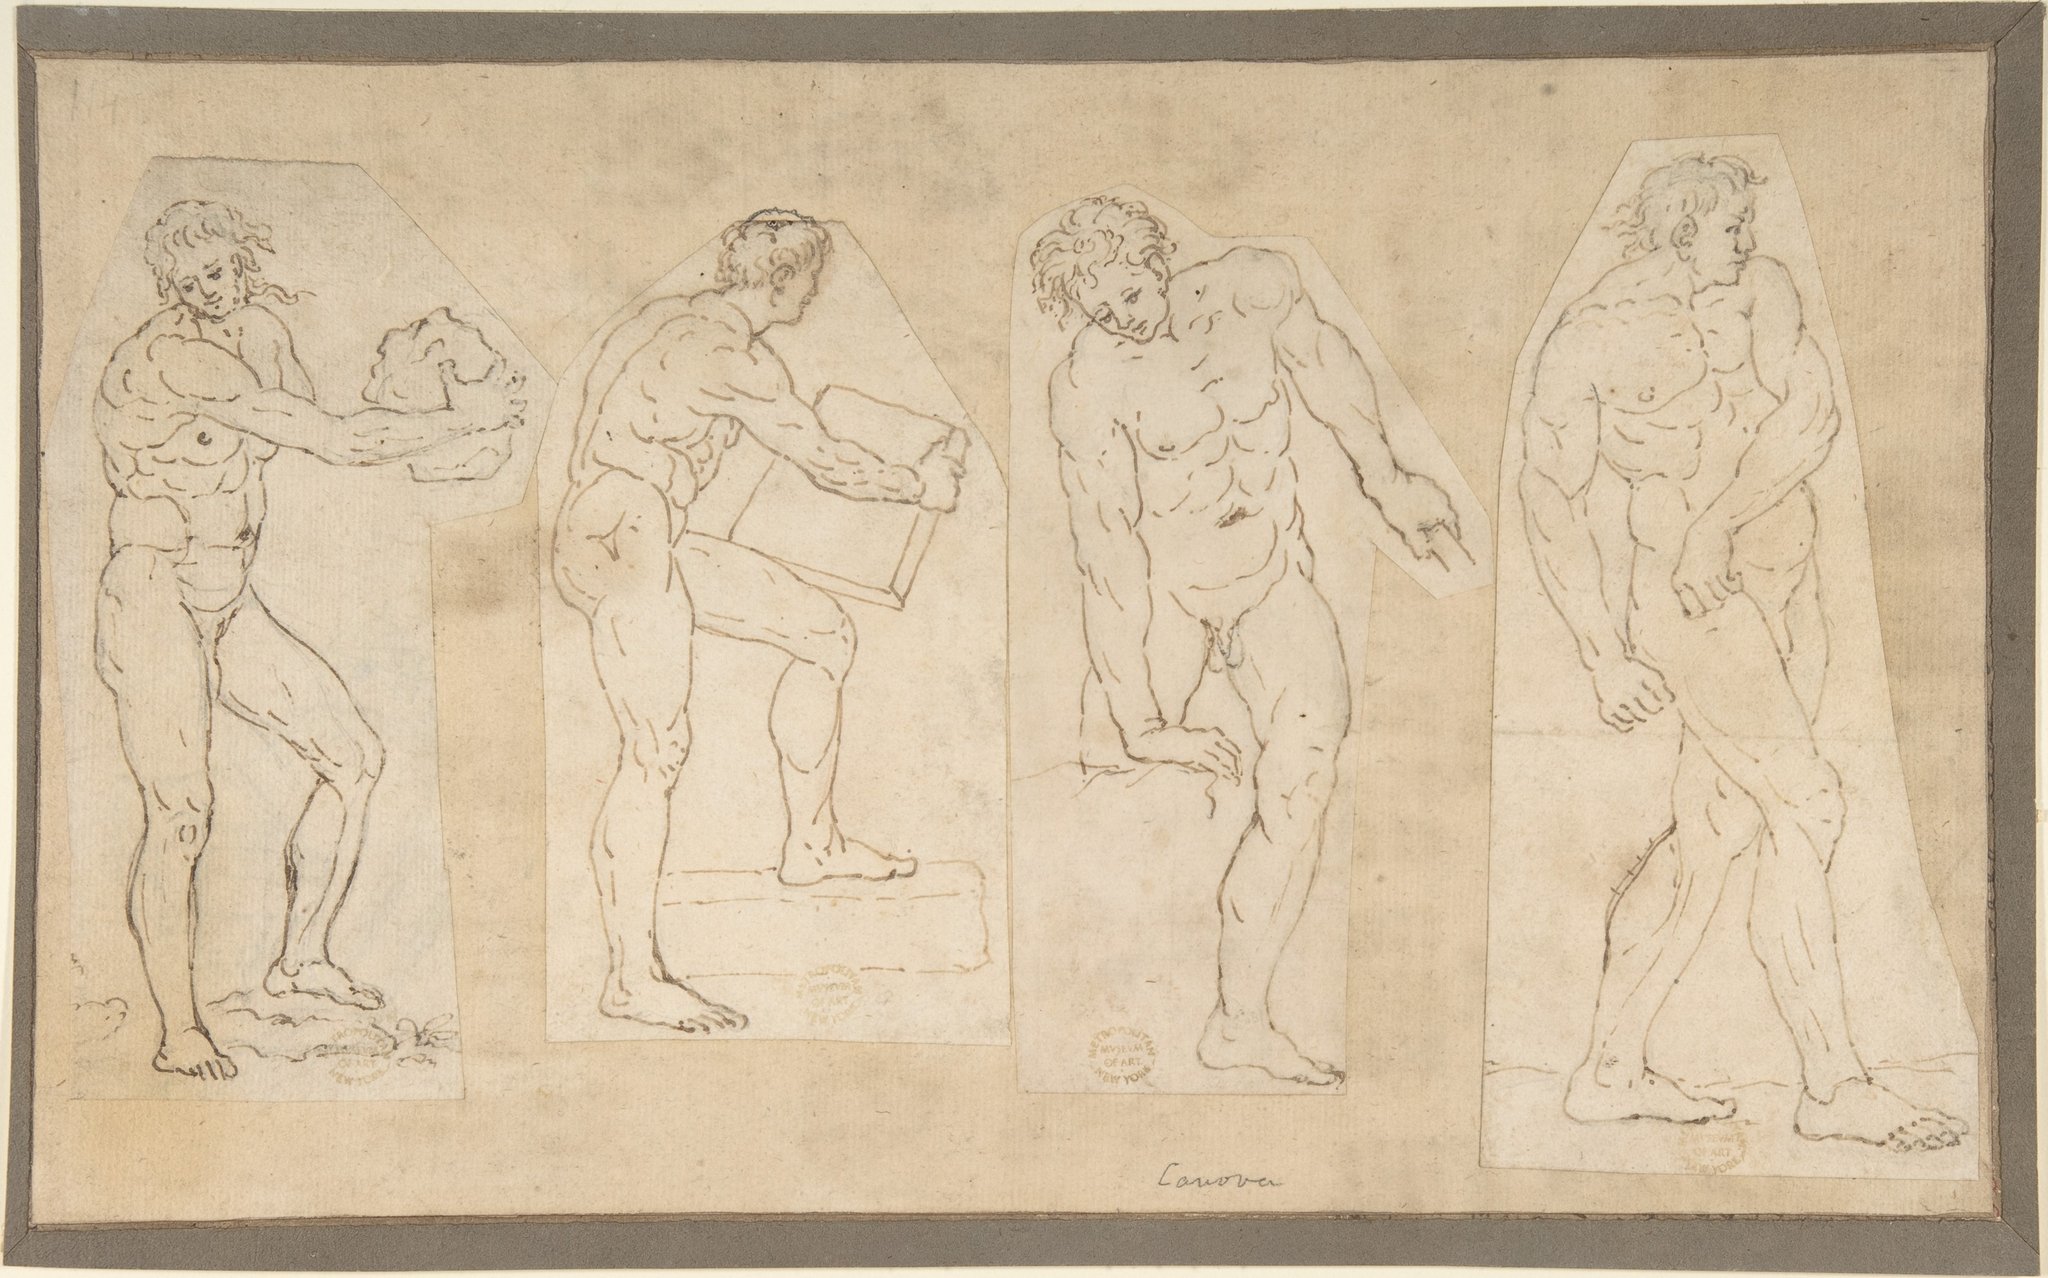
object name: drawing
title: Four Studies of Nude Men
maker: anonymous, italian, early 19th century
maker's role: artist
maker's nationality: italian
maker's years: 1800-1825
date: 1757-1822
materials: ink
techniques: pen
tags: male nudes